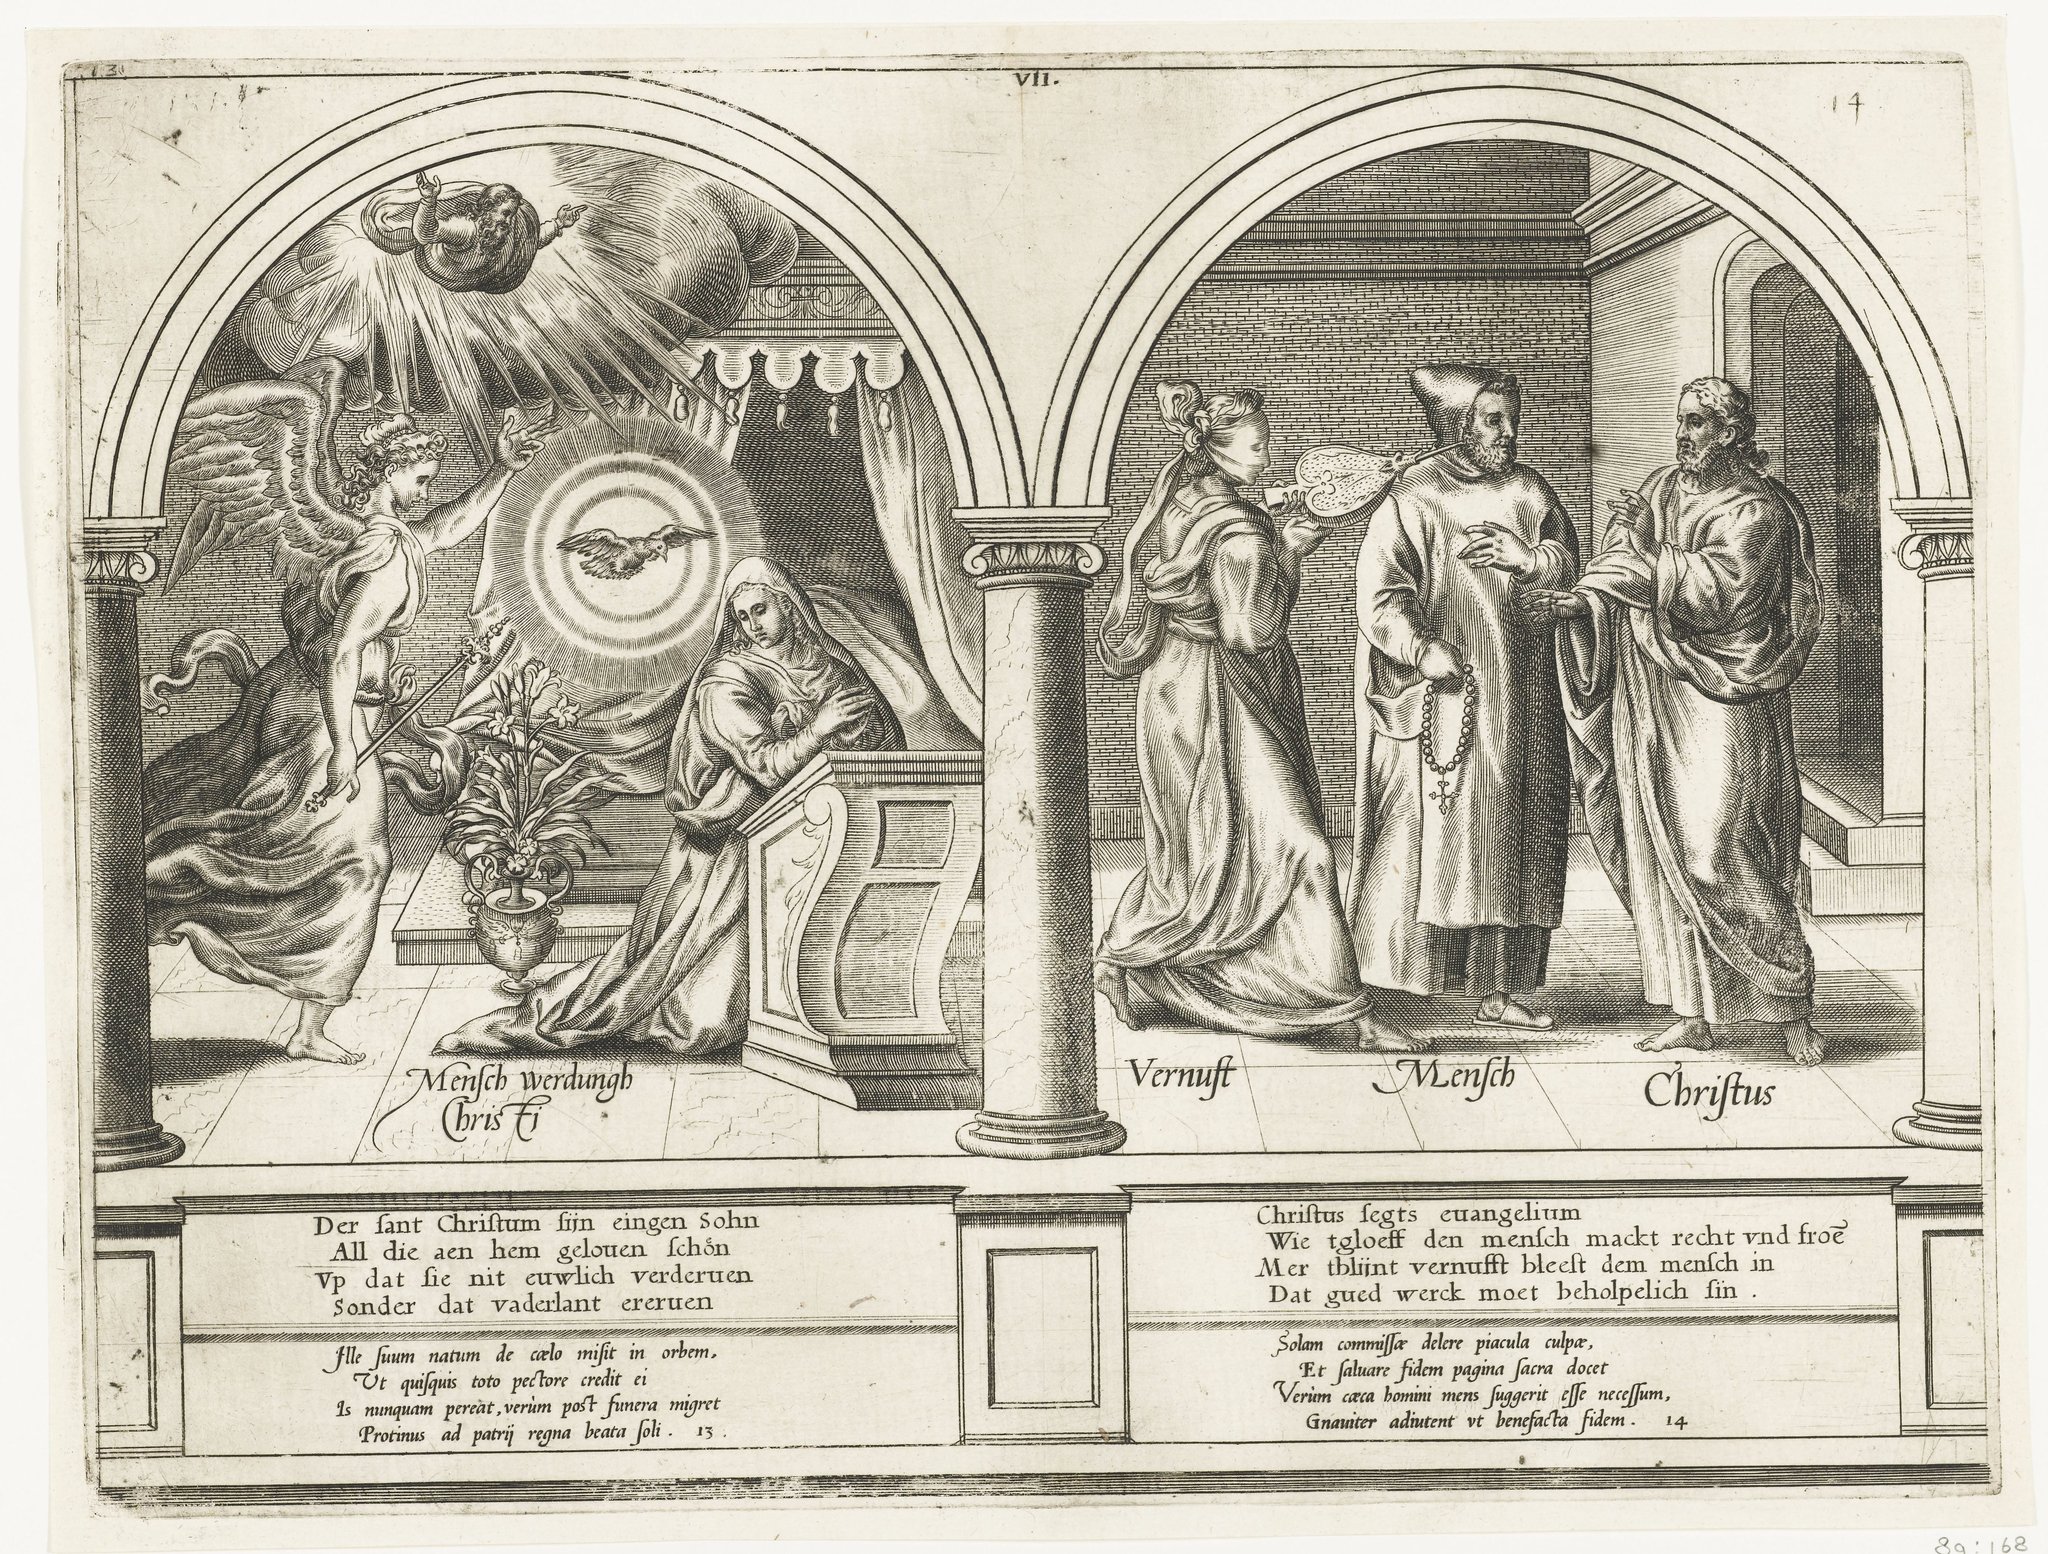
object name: print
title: Annunciatie /De Mens tussen Vernuft en Christus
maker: frans huys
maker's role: print maker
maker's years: 1522-1562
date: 1546-1562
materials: paper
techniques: engraving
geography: antwerp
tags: the annunciation: mary kneeling, doctrine on original sin, and redemption, stupidity, poverty of intellect; 'stupidità overo stolidità' (ripa) (+ personification), the incarnation ~ christ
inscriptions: collector's mark: Lugt 2228, collector's mark: Lugt 2760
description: Twee bijbelse allegorieën in architecturale omlijsting. Links de verkondiging aan Maria door de engel Gabriël met God de Vader en de Heilige Geest als duif. De voorstelling verbeeldt de menswording van Christus. Rechts de Mens gekleed in habijt en met rozenkrans tussen de personificatie van het blind Vernuft en Christus. De Mens is doof voor de woorden van Christus en luistert naar de inblazingen van het Vernuft om op zijn goede werken te vertrouwen. Onder beide voorstellingen een vierregelig vers in het Nederduits en een vierregelige tekst in het Latijn. Nummer 13 en 14 uit een reformatorische serie over de zondigheid en rechtvaardiging van de mens.